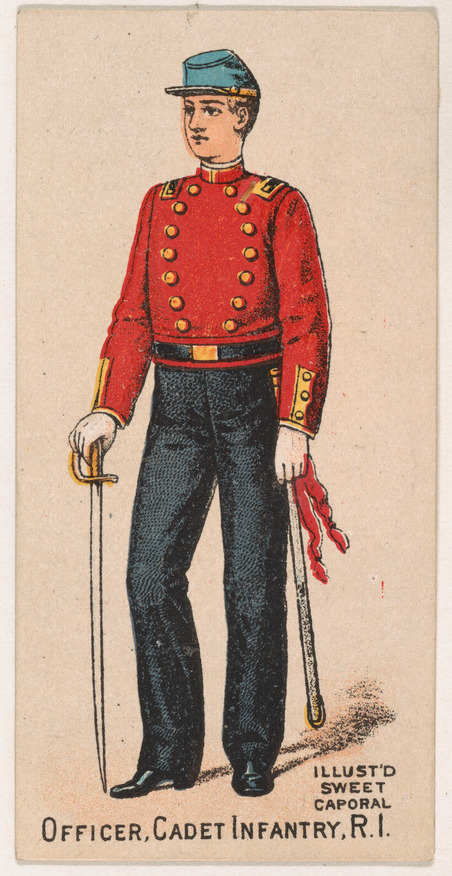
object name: print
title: Officer, Cadet Infantry, Rhode Island, from the Military Series (N224) issued by Kinney Tobacco Company to promote Sweet Caporal Cigarettes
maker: kinney brothers tobacco company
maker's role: publisher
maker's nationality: american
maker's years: 1869-2011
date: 1888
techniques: color lithograph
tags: military,swords,men